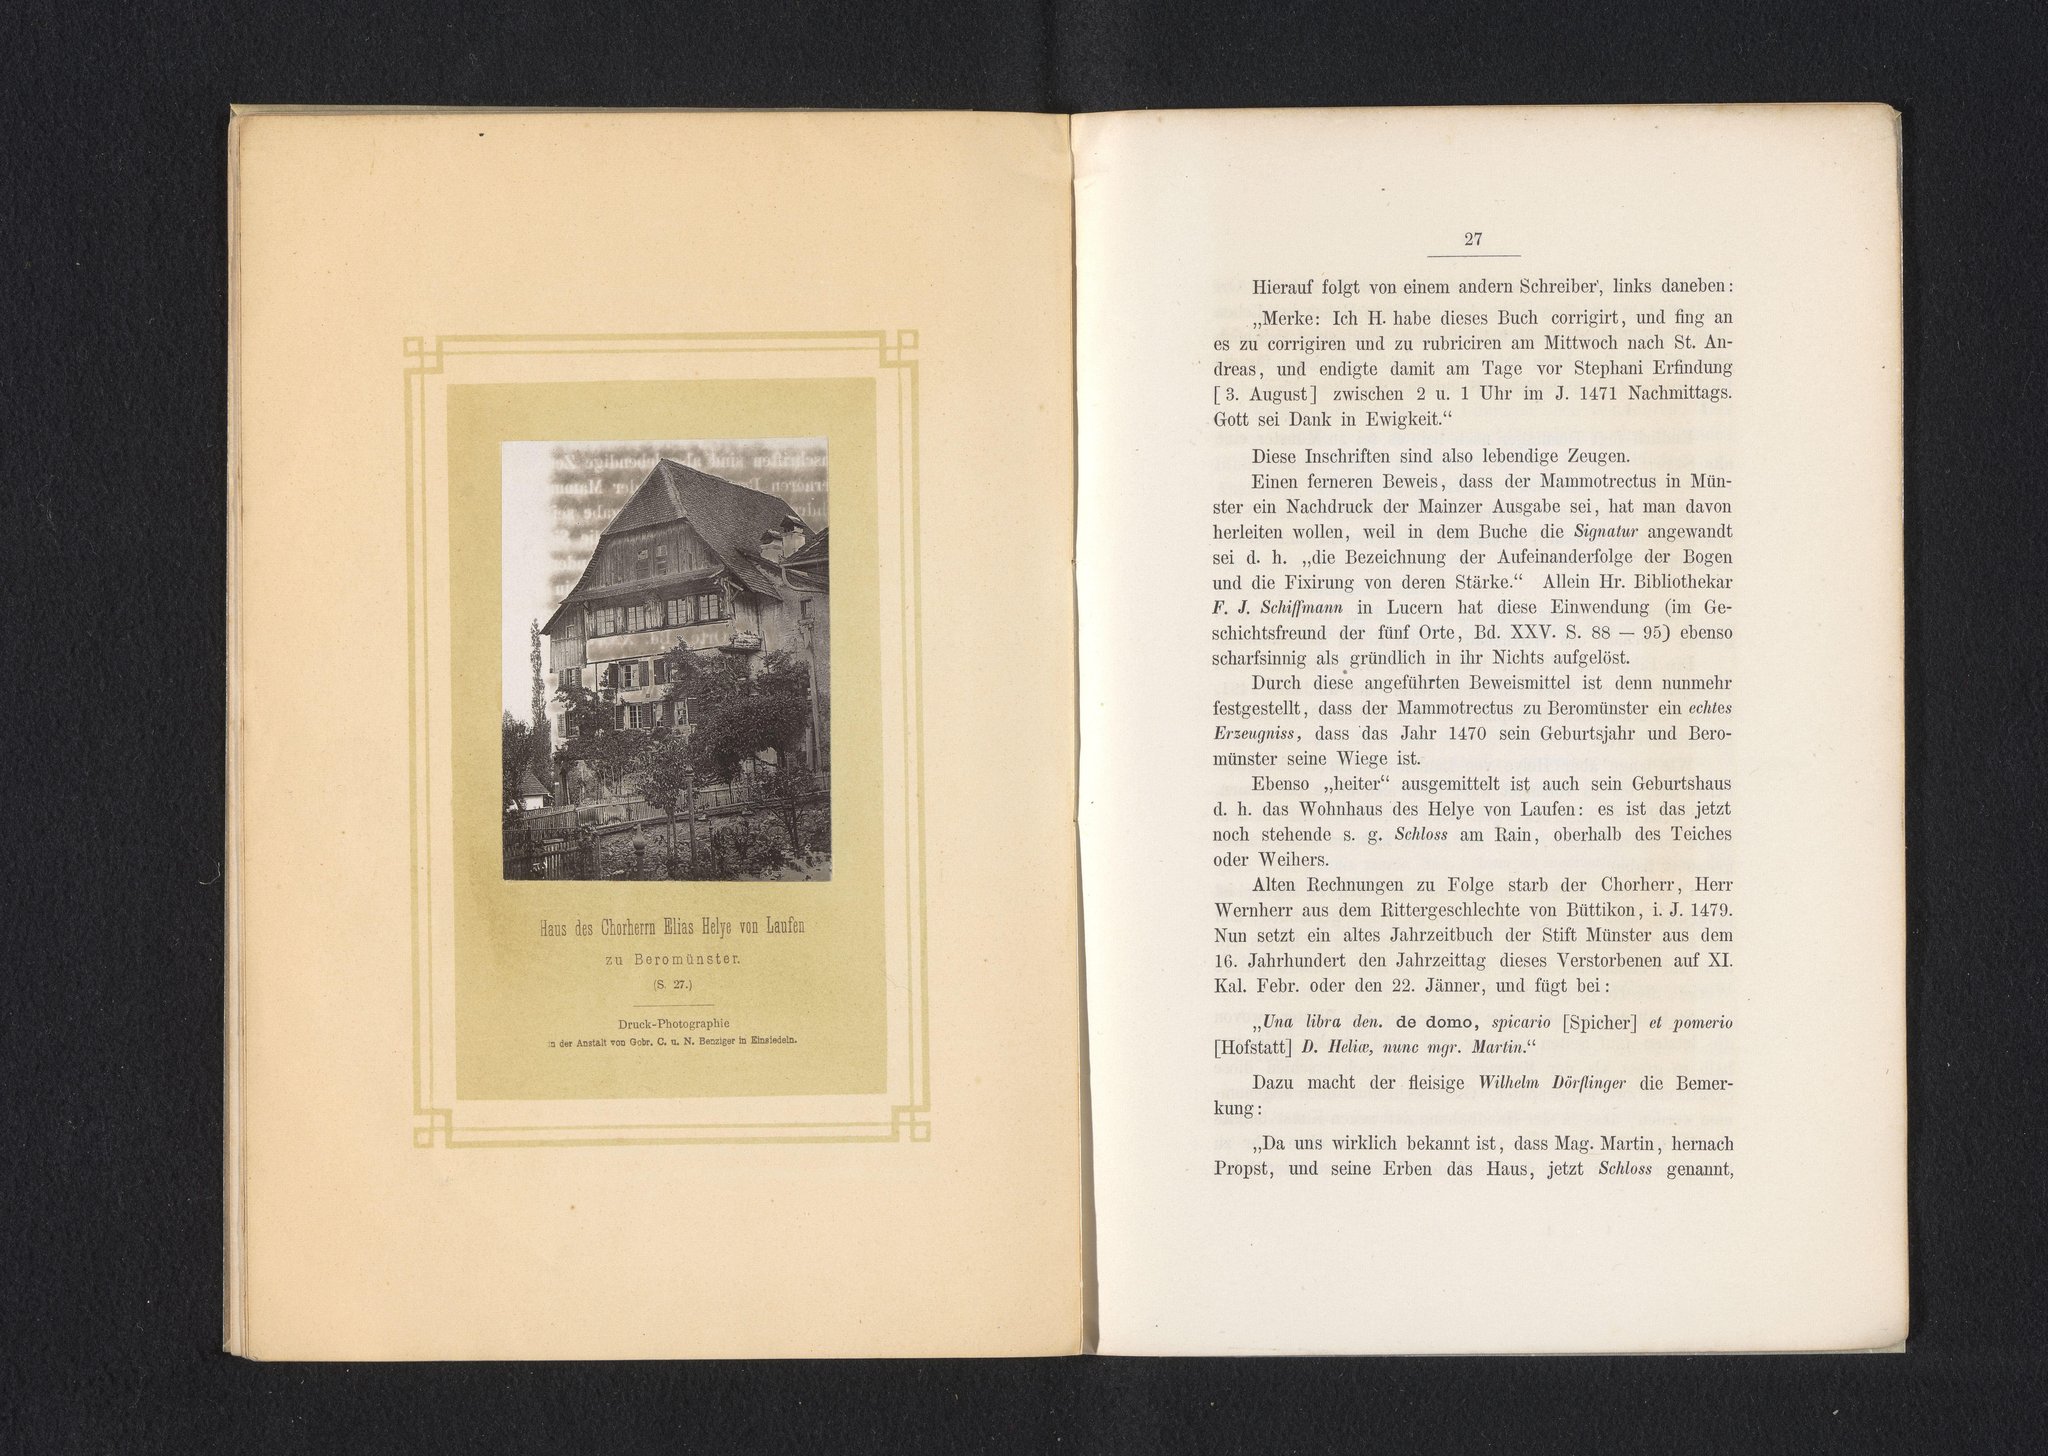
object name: page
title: Gezicht op het huis van Elias Heyle von Laufen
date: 1865-1870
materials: paper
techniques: photograph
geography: einsiedeln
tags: front façade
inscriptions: inscription: ‘zu Beromünster./ (S 27.)’